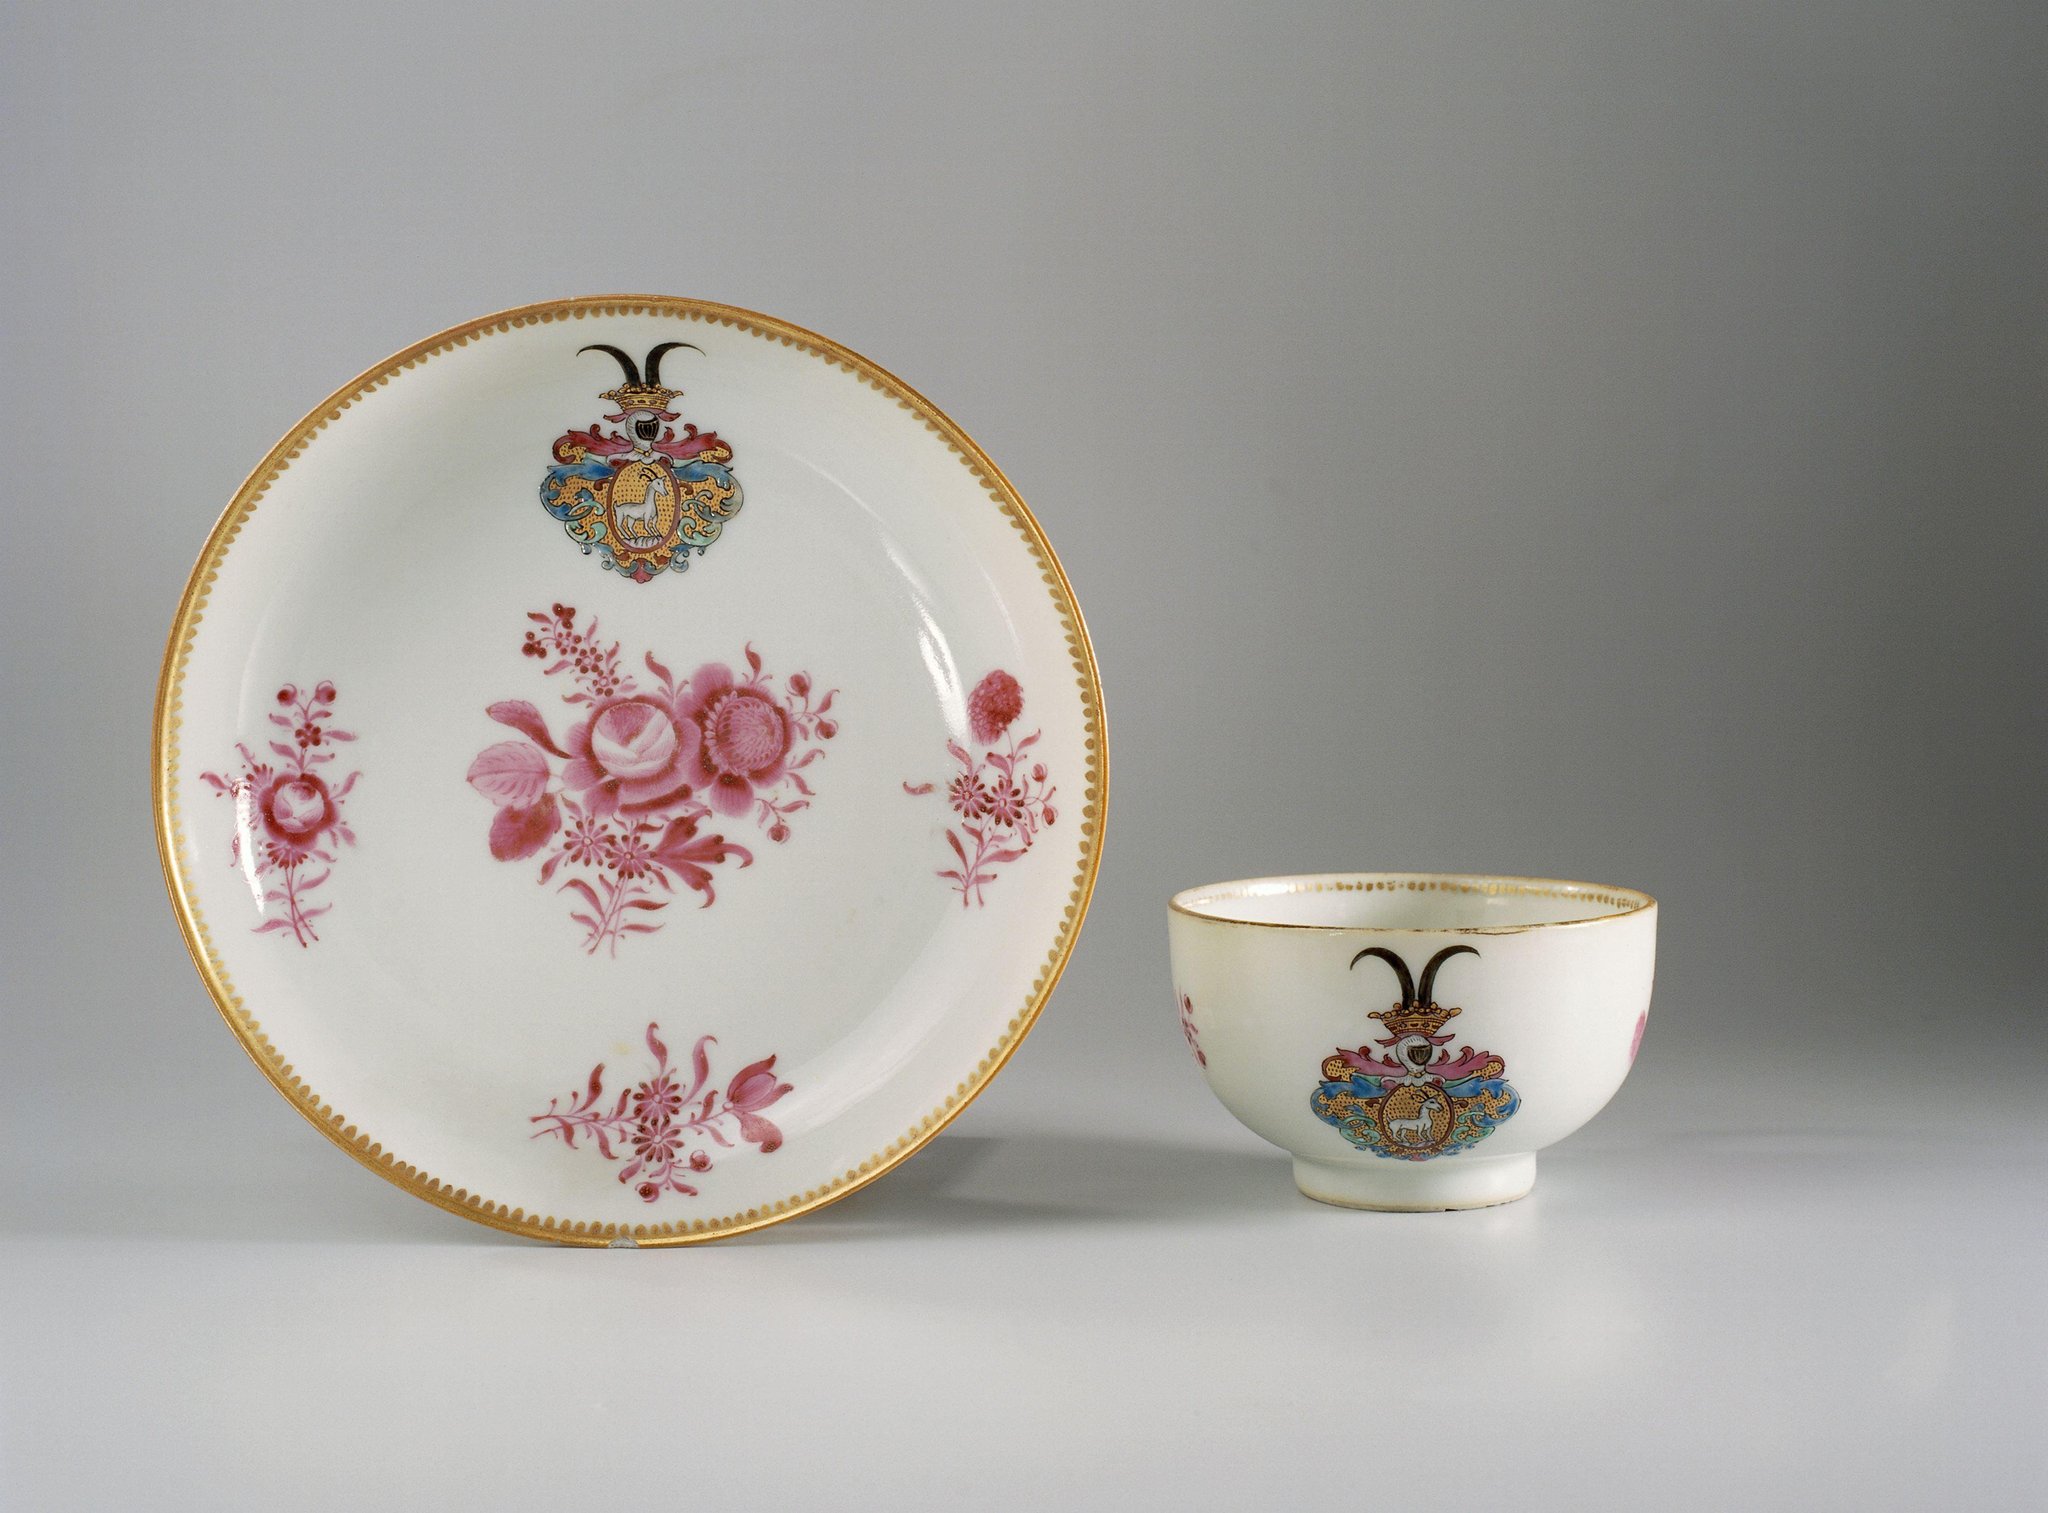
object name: platter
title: Saucer with flower bouquets and a coat of arms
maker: Anonymous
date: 1750-1774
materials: glaze, gold, paint, porcelain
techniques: firing, gilding, turning, vitrification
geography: china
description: Schotel van porselein, beschilderd op het glazuur in blauw, rood, roze, groen, zwart en goud. Op het plat van de schotel een boeket met bloemen en drie bloemtakken (en camaïeu) en een ongeïdentificeerd familiewapen. Op het wapen een ram op een rots tegen een goud gespikkelde achtergrond. Het helmteken is een kroon met twee horens. Het dekkleed bestaat uit bladranken. Op de binnenrand een decoratieve band. Een chip in de rand van de schotel. Wapenporselein met emailkleuren.